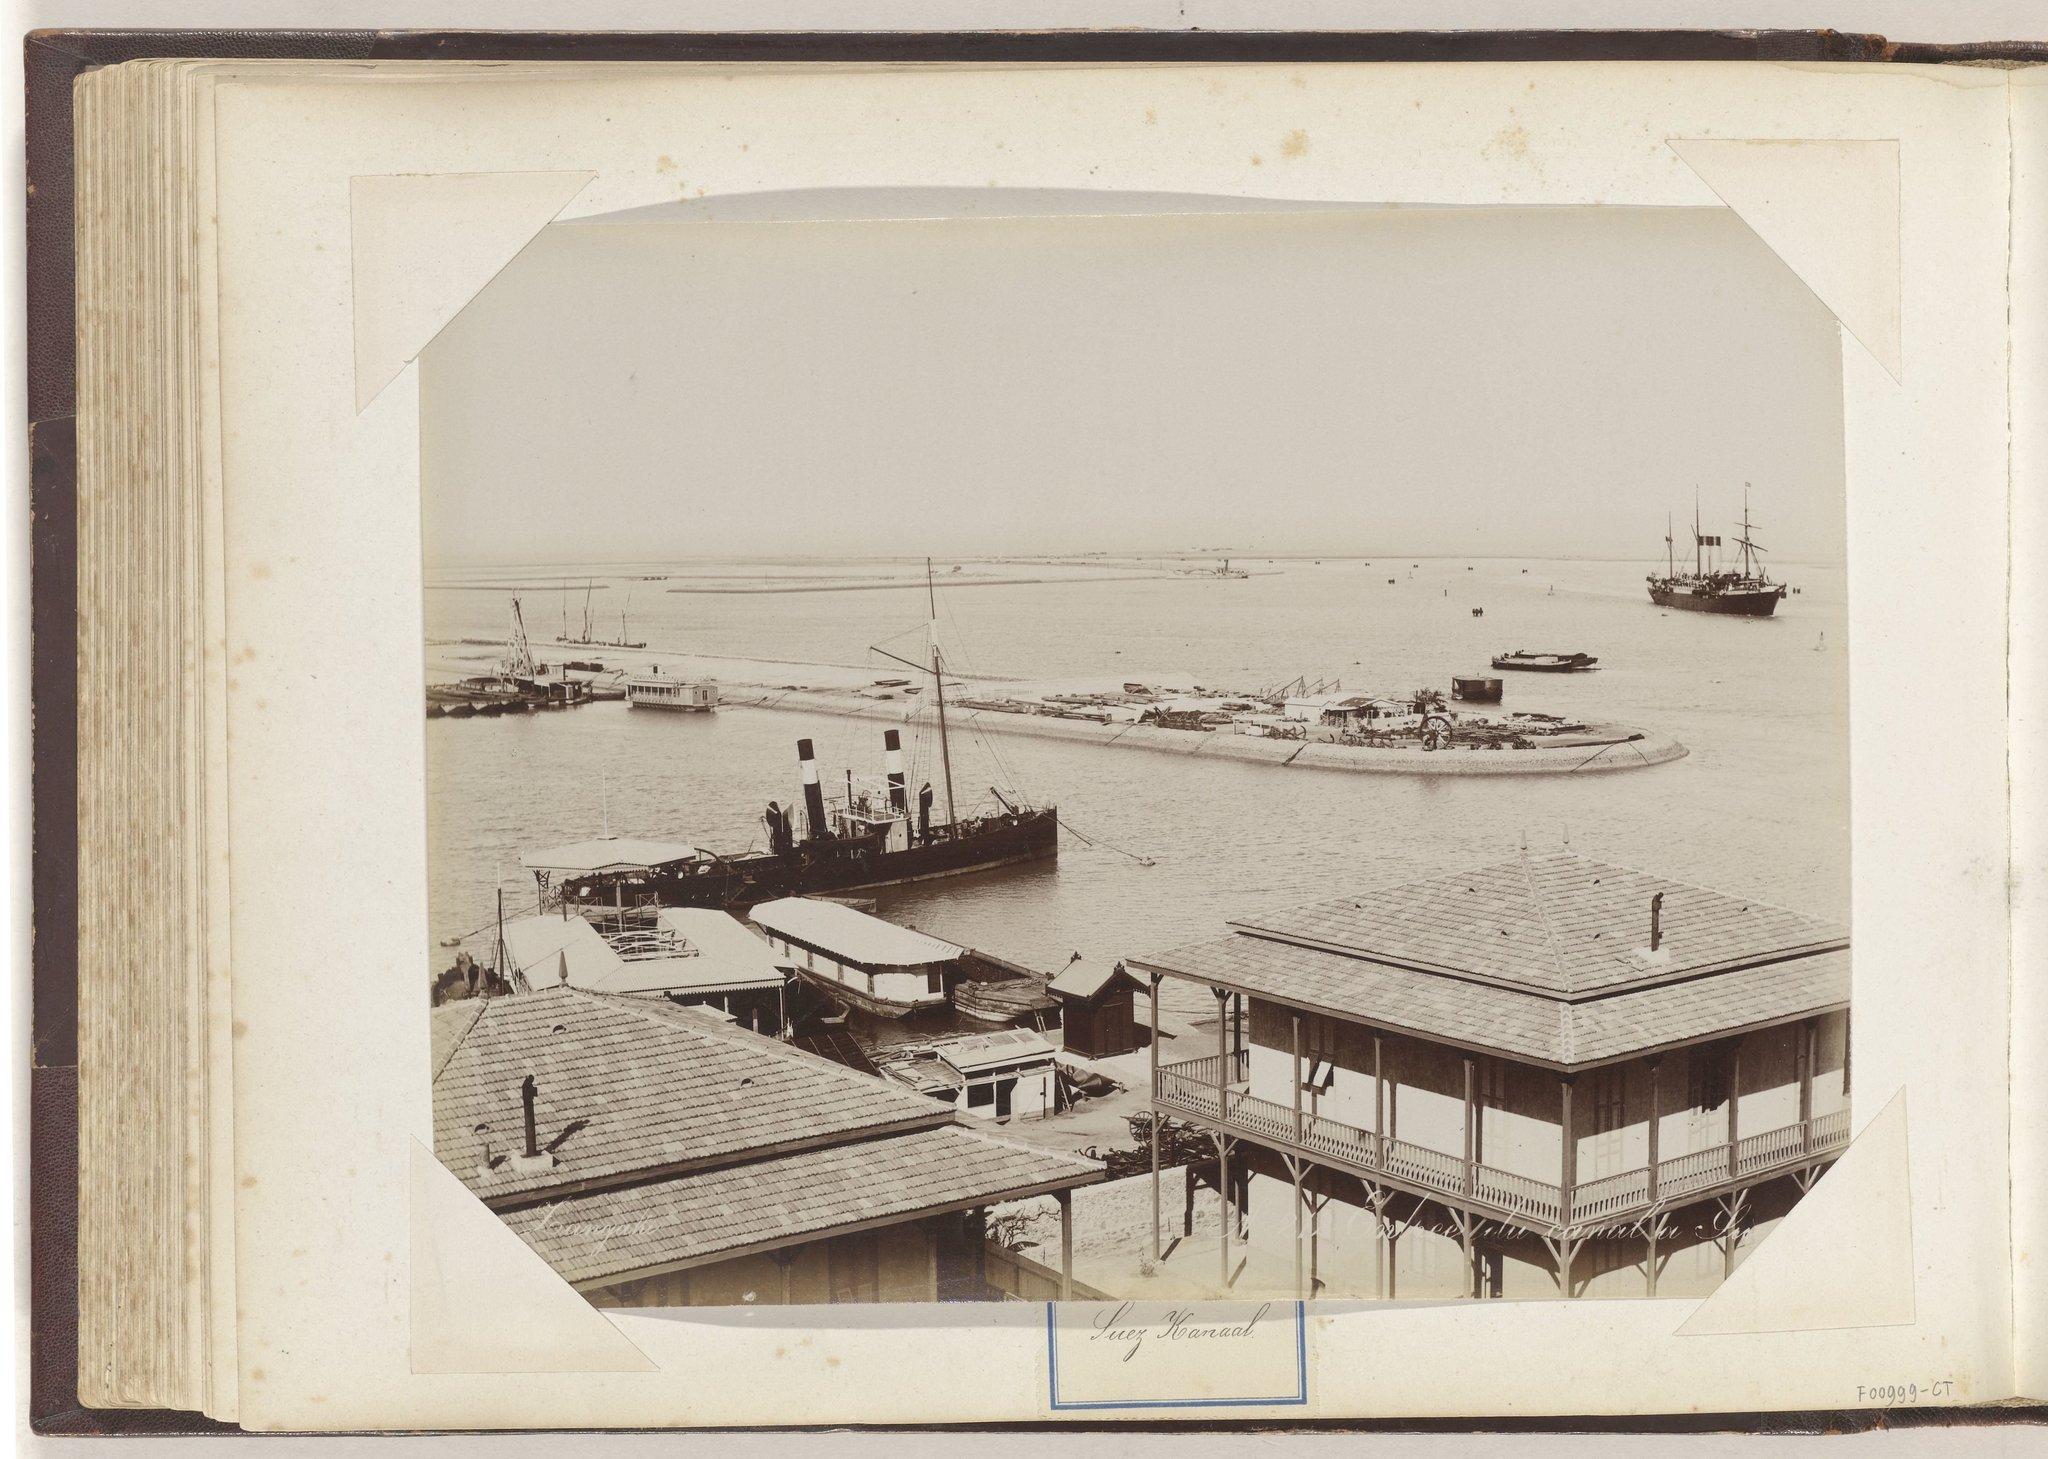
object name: photograph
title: Gezicht op de ingang van het Suezkanaal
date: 1870-1890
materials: paper, photographic support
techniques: albumen print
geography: suez canal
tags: canal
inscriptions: negative number: ‘212’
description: Onderdeel van Album met 191 foto's van een reis naar en door Zuid-Afrika.